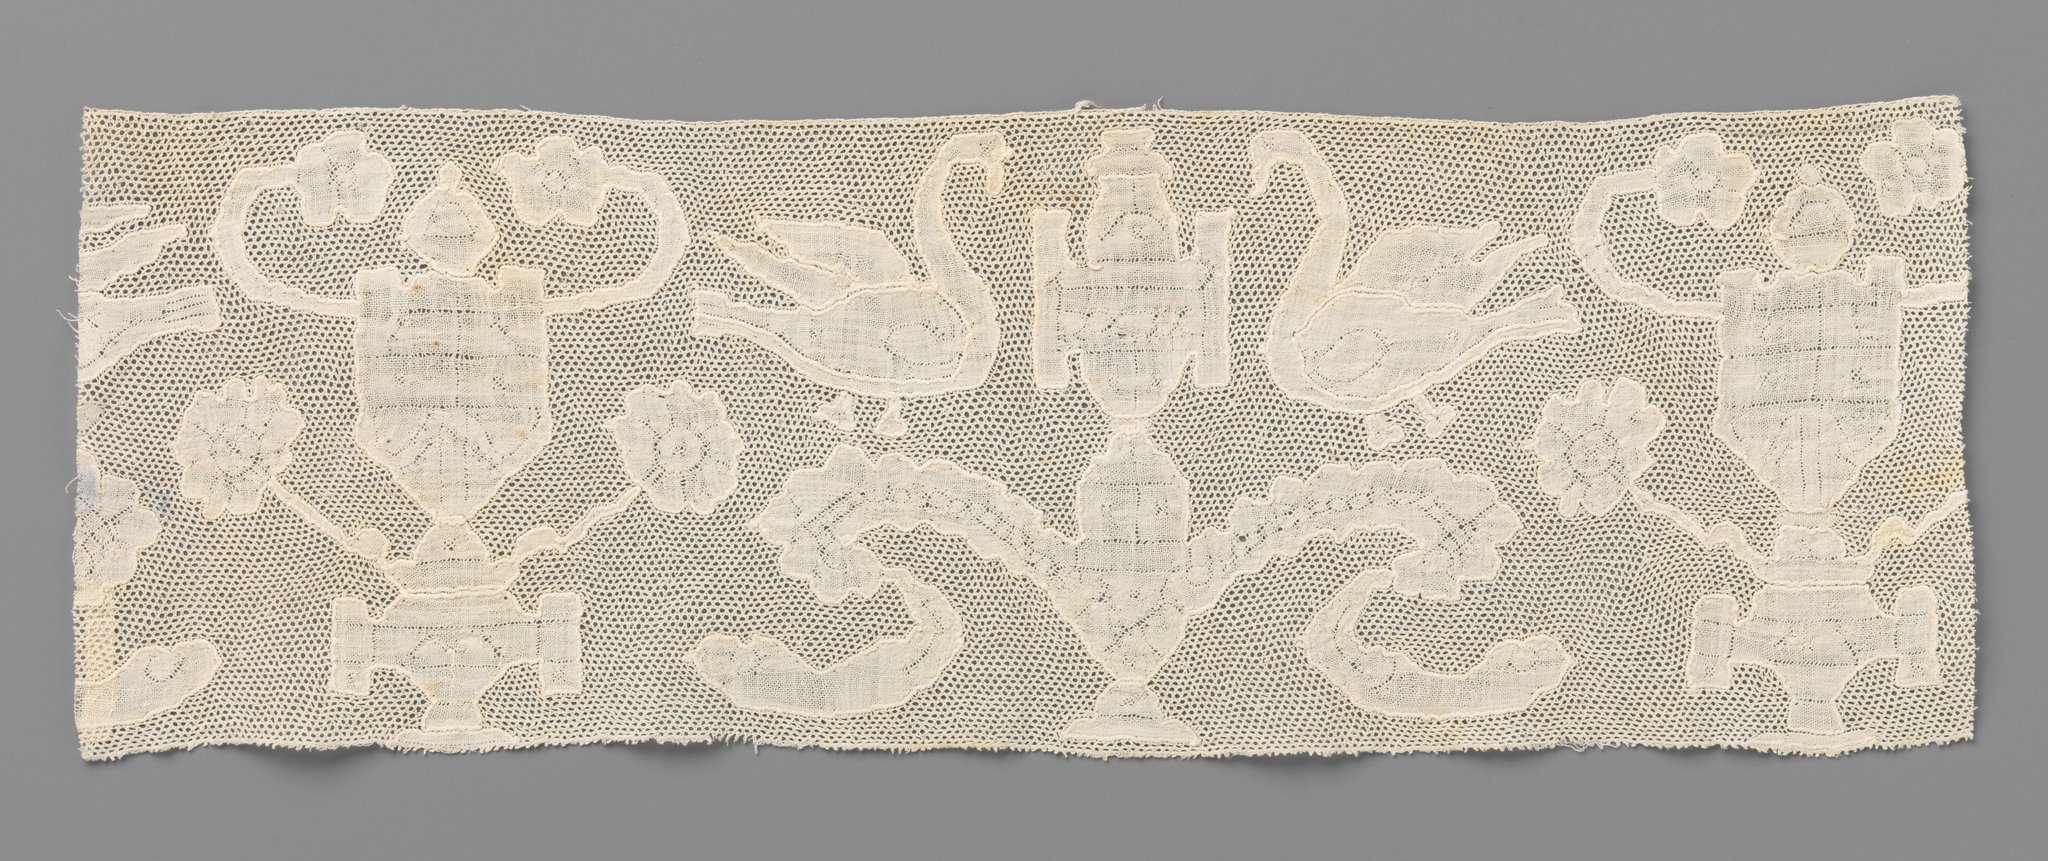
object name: strip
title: Strook kloskant met vaas of urn tussen twee zwanen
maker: Anonymous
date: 1800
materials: linen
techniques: lace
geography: flanders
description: Strook naturelkleurige kloskant, Antwerpse pottekant. Het zich herhalende en symmetrische patroon bestaat afwisselend uit een urn of vaas tussen twee naar elkaar toegewende zwanen en een grotere urn of vaas zonder zwanen. De motieven zijn met elkaar verbonden door een maasgrond, de Parijse grond. De motieven zijn gemaakt in linnenslag met uitsparingen en dikkere contourdraden. Boven- en onderzijde van de strook zijn recht afgewerkt, waarbij de onderzijde is voorzien van picots.